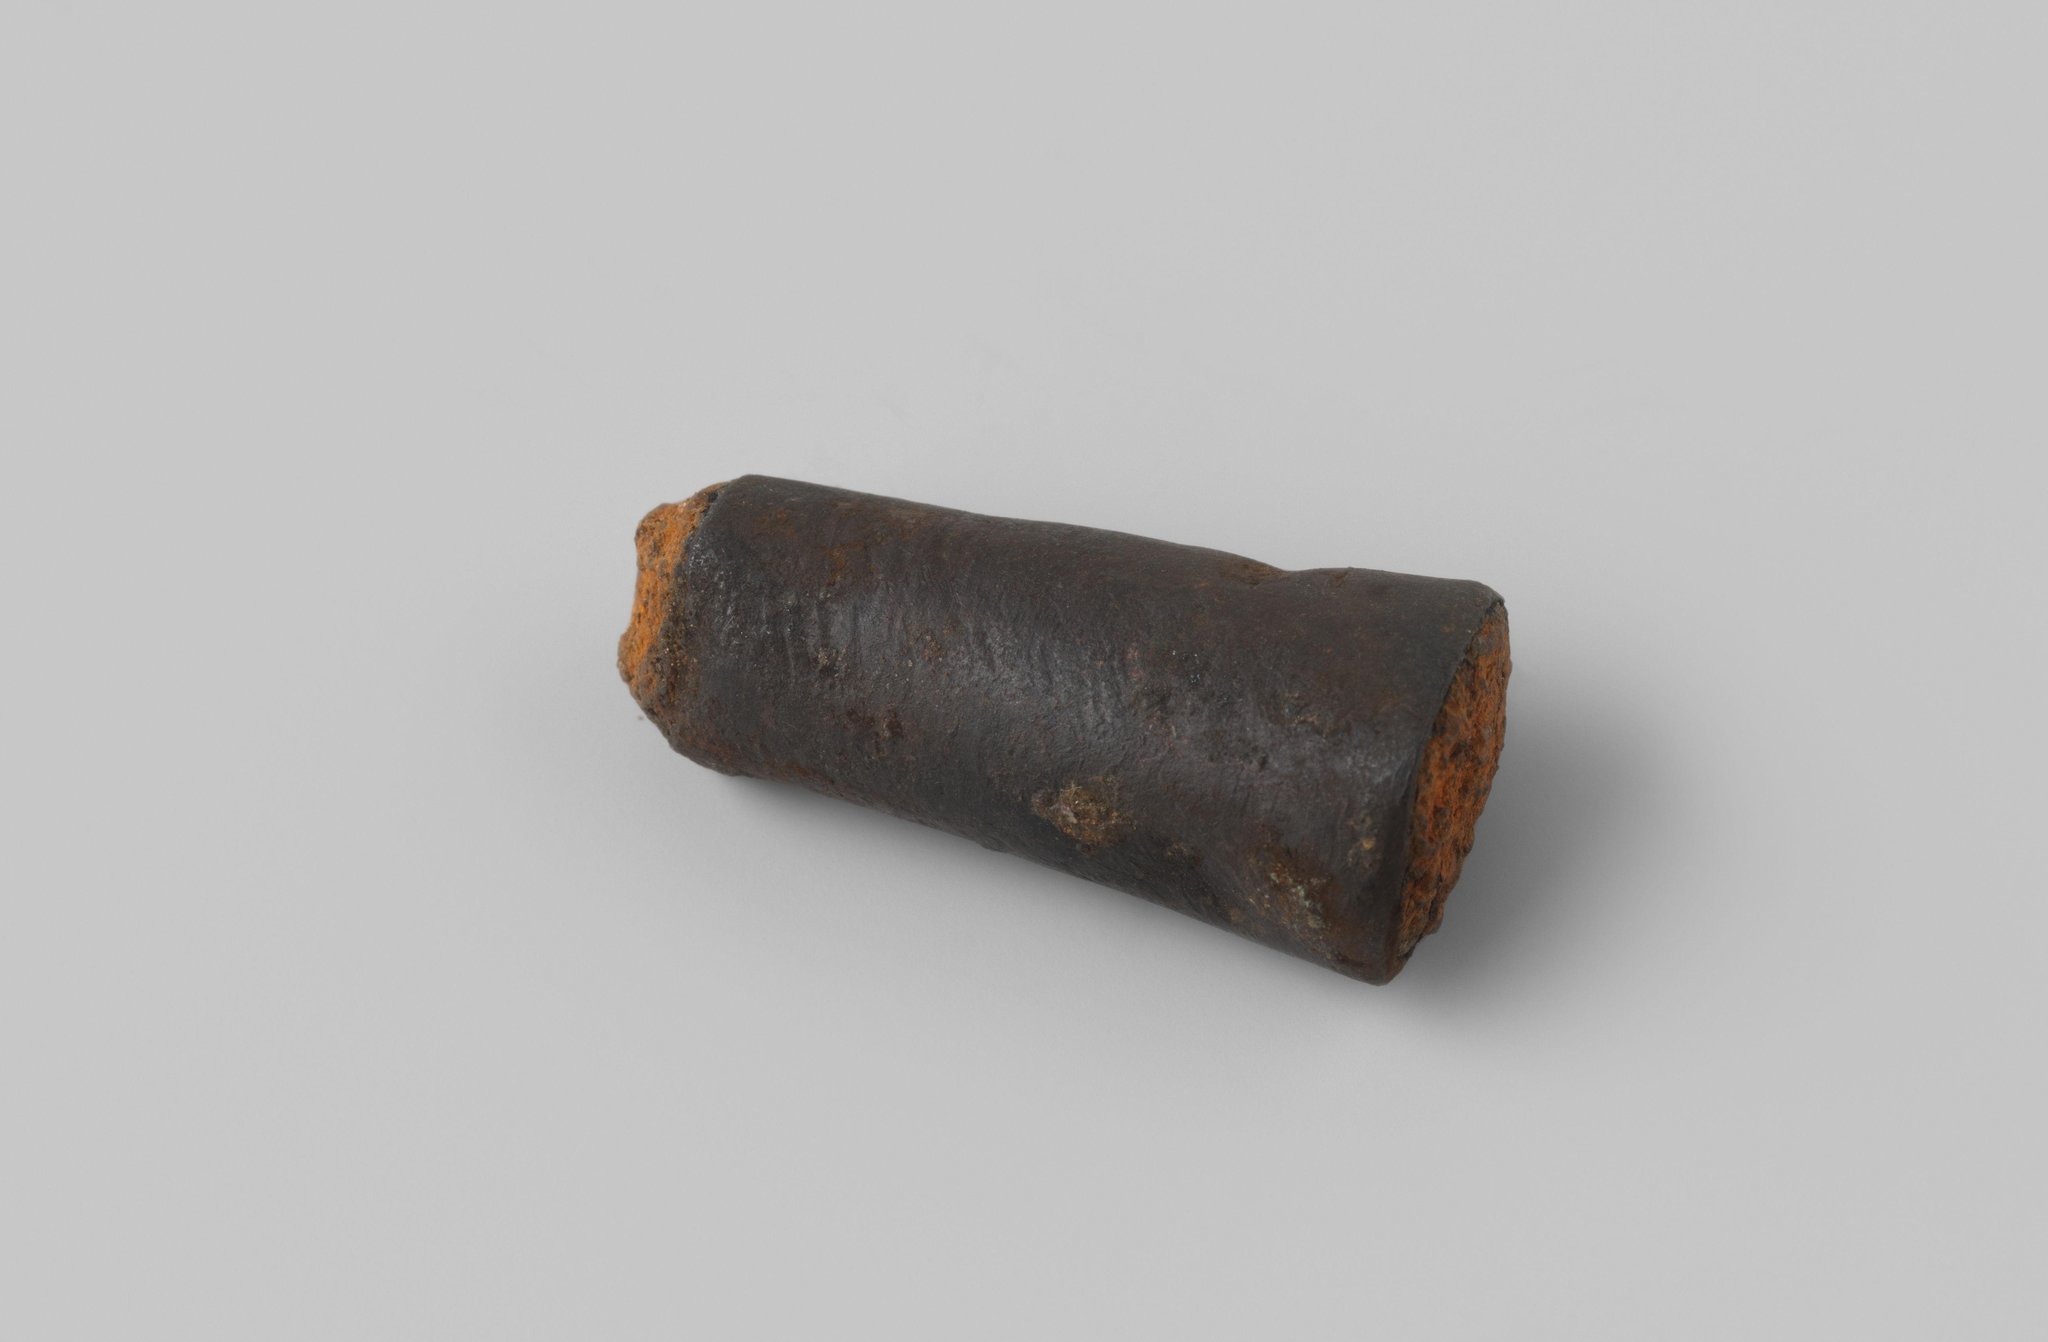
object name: rammer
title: Fragment laadstok van een handwapen uit het wrak van de Oost-Indiëvaarder Hollandia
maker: Anonymous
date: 1700-1743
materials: copper, wood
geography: netherlands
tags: verenigde oostindische compagnie, hollandia (schip), annet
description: Hand weapon, ramrod; fragm, end, id. NG 1980-27H1163.